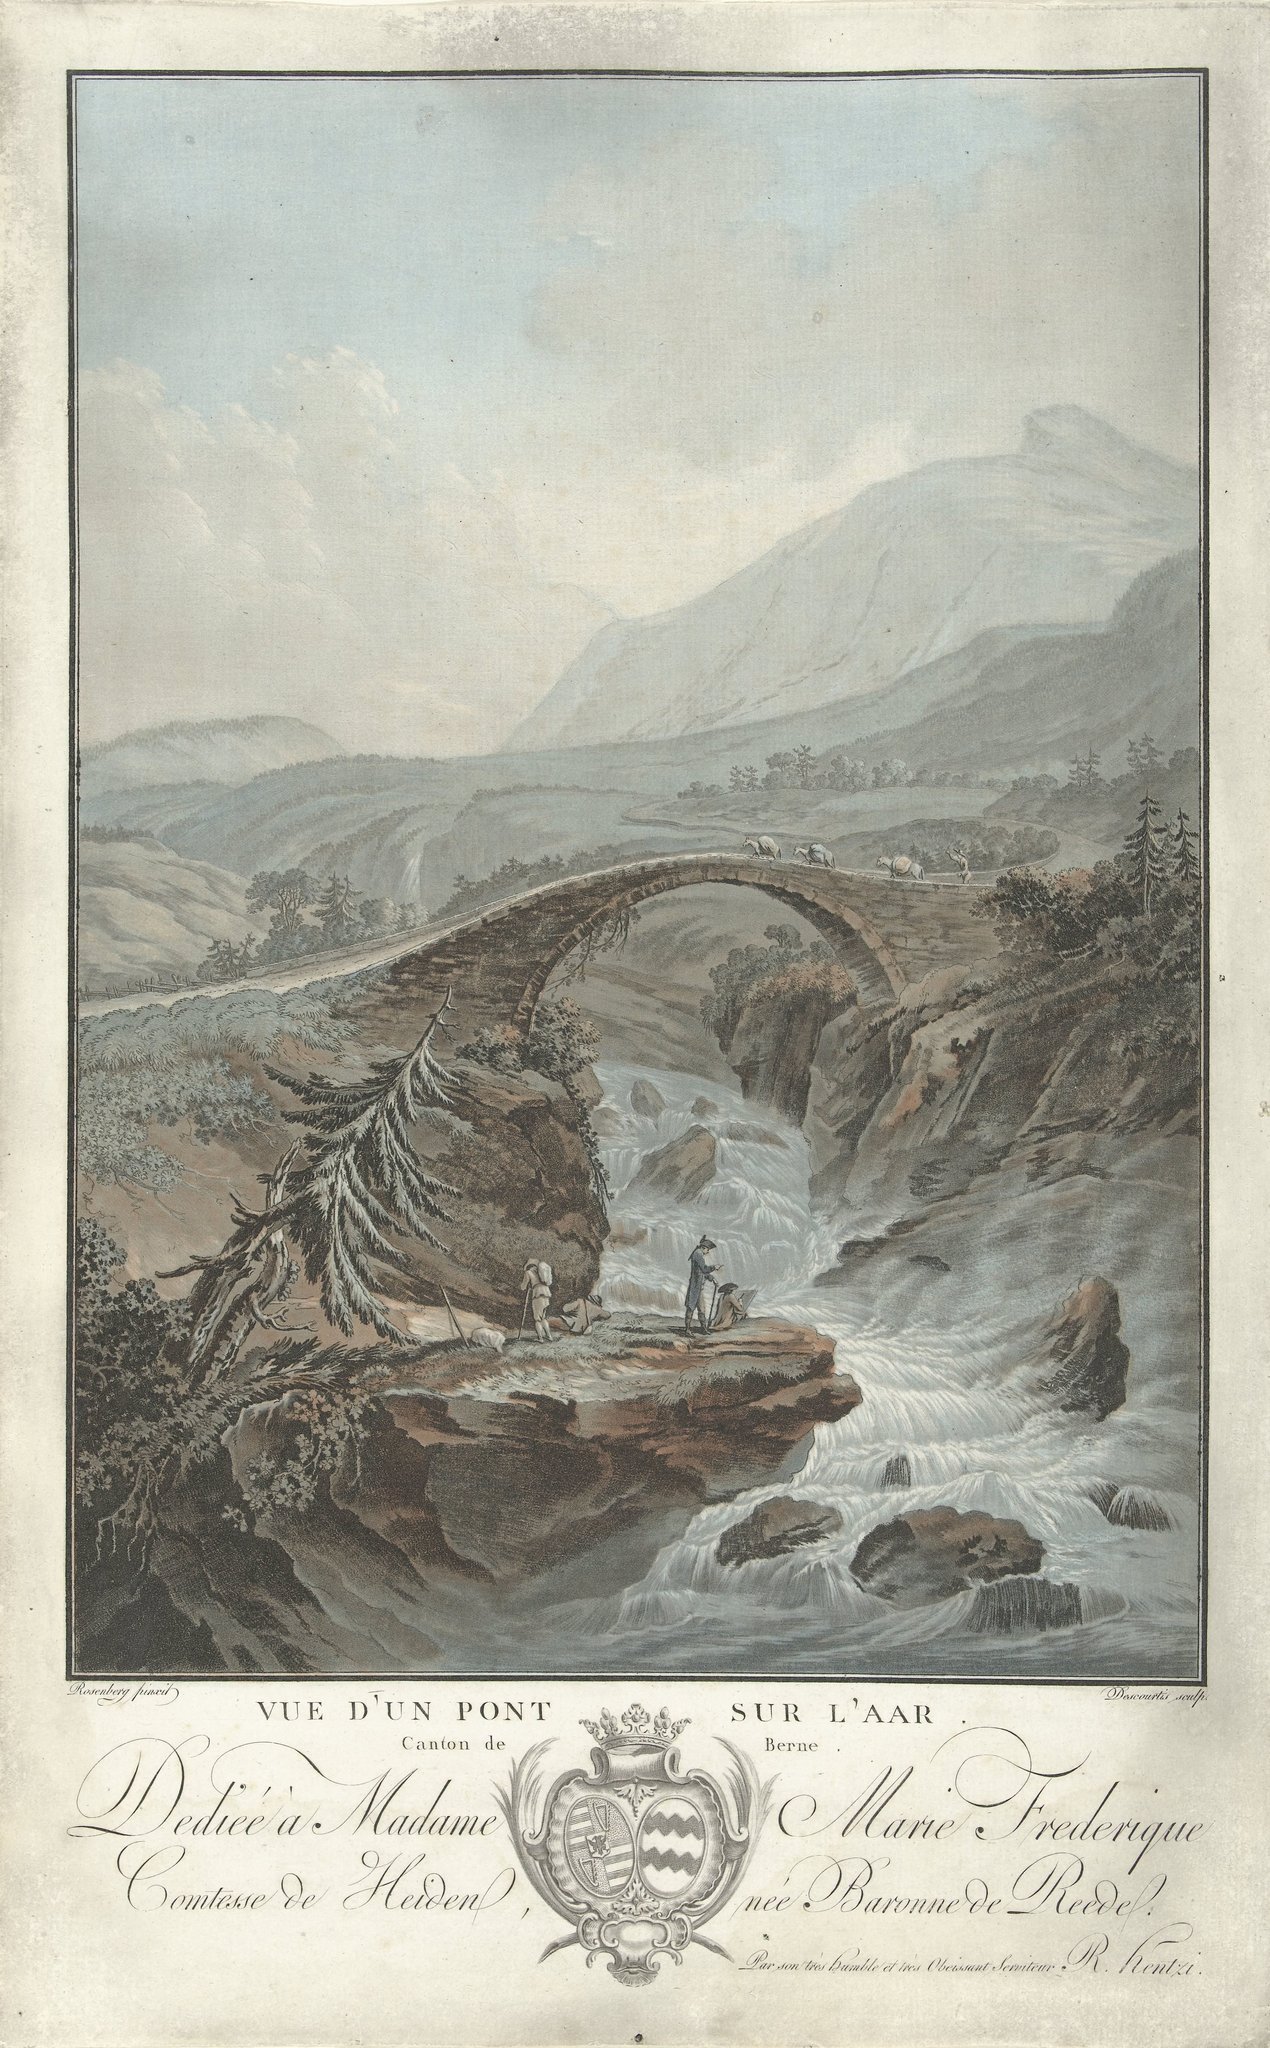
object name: print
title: Rivier de Aare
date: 1763-1785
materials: paper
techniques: etching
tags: river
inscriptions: collector's mark: Lugt 2228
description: Mogelijk afkomstig uit de serie van 43 prenten met Zwitserse landschappen, uitgegeven door J. Yntema te Amsterdam in 1785.